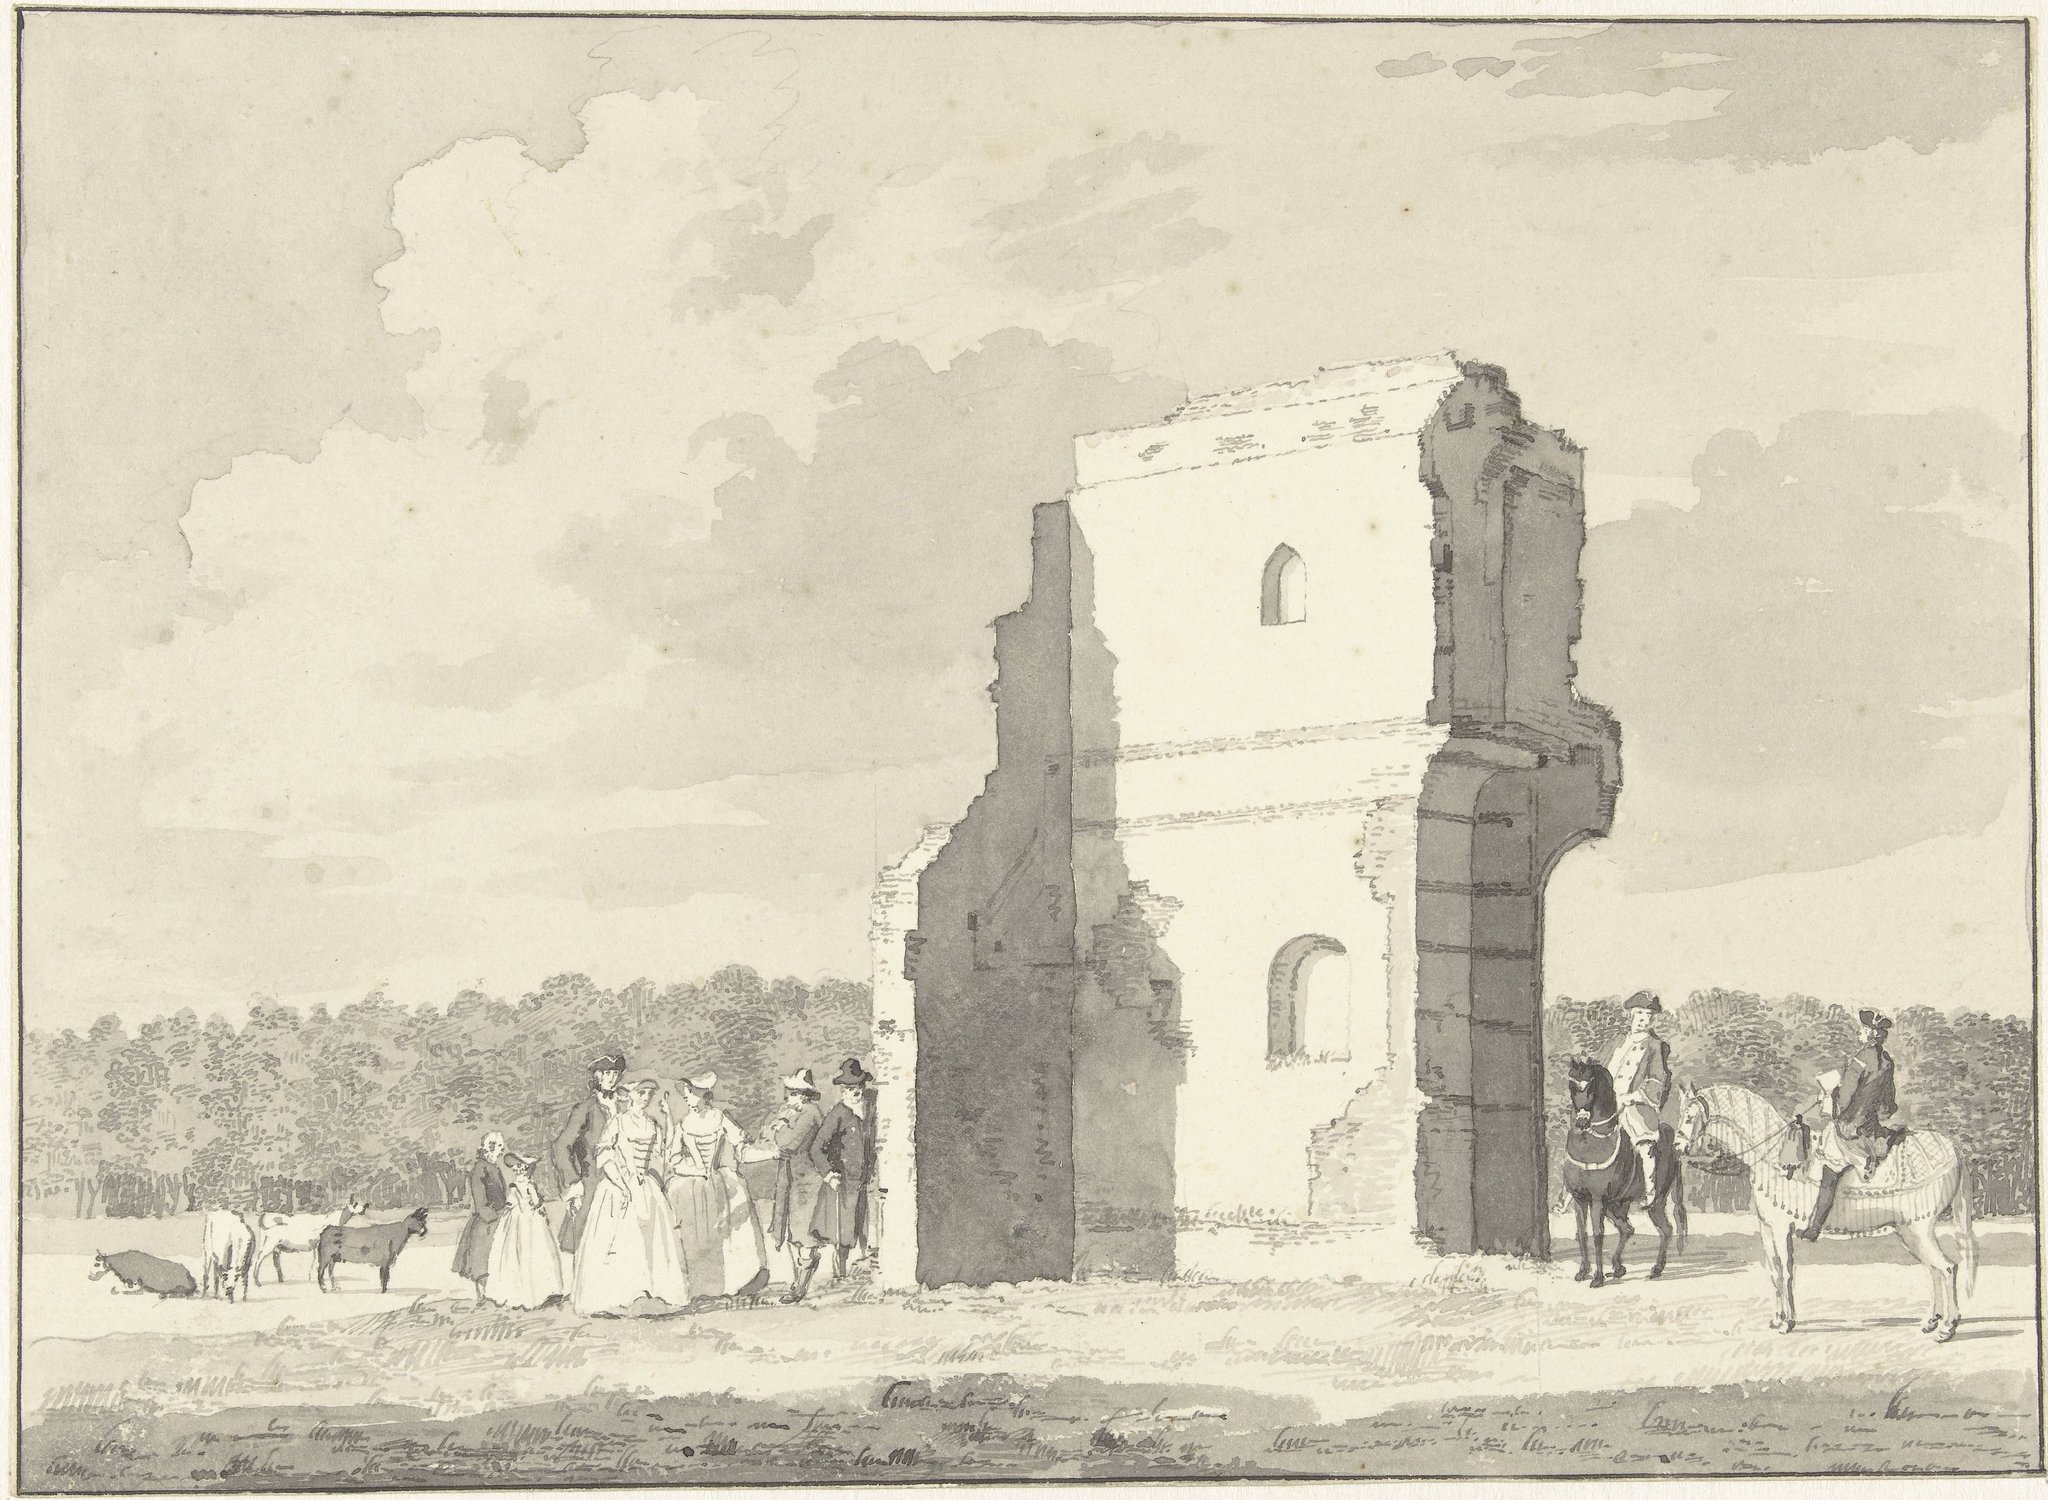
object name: drawing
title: Twee ruiters en een gezelschap te voet bij een muur van een ruïne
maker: cornelis pronk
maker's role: draughtsman, painter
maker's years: 1691-1759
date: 1701-1759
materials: ink, paper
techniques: brush, pen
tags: ruin of a building ~ architecture